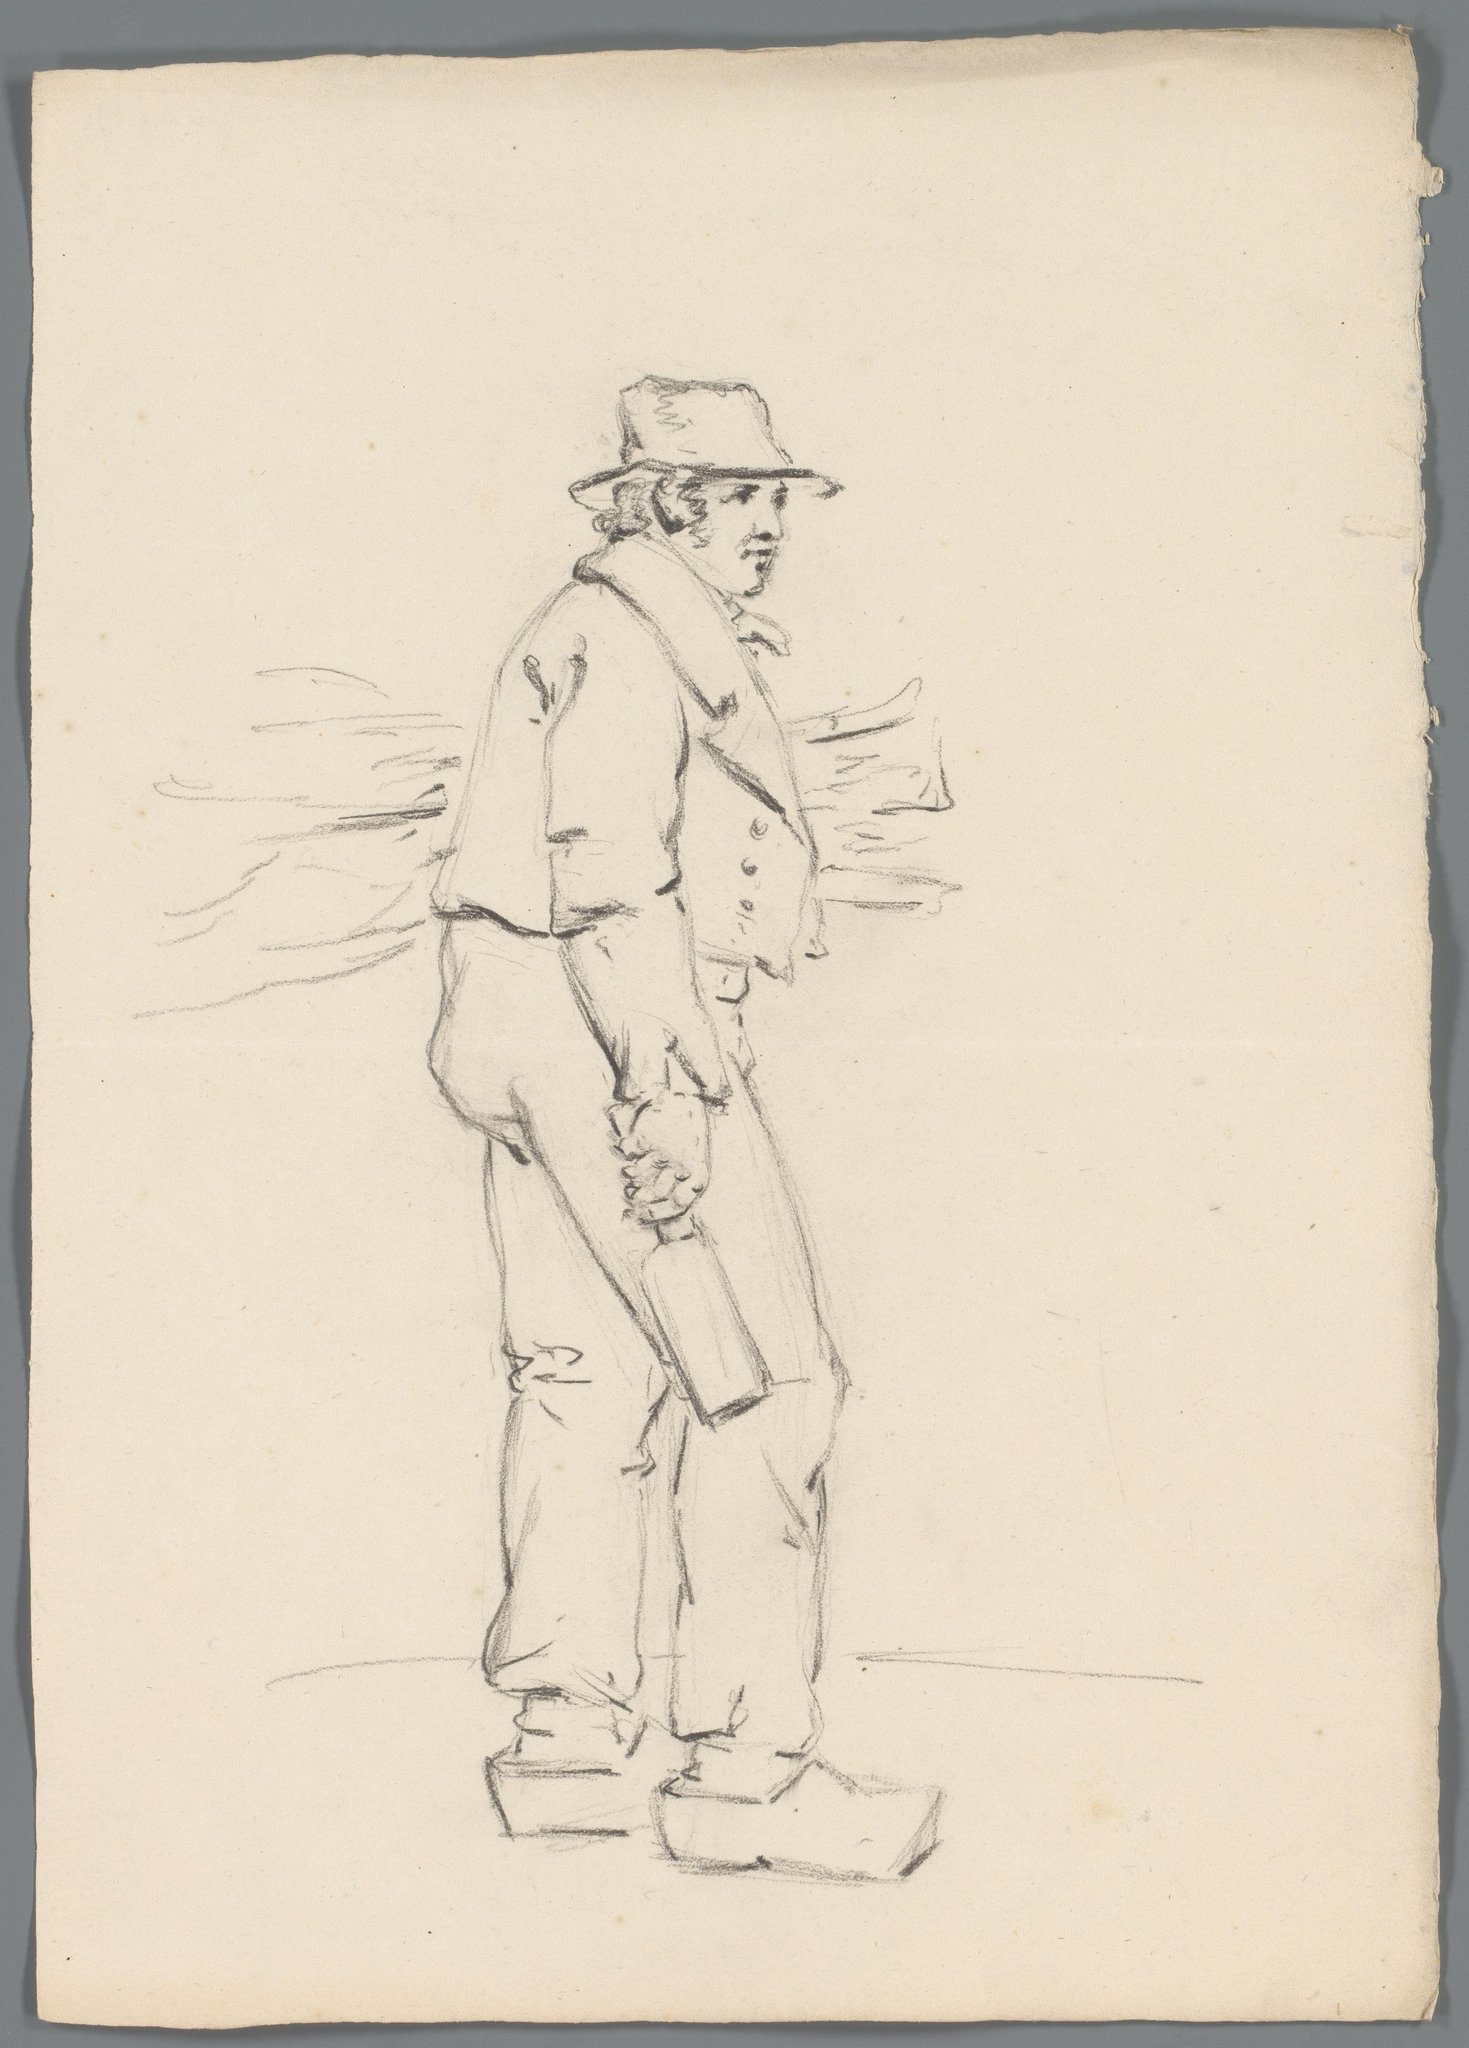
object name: drawing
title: Man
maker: Anonymous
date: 1820-1830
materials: chalk, paper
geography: the hague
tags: wooden shoes, clogs, adult man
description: Tekeningen waarschijnlijk ontstaan bij het Haagse kunstgenootschap ‘Tot Nut der Tekenkunst’, waar twee keer per week tekenavonden werden georganiseerd met geklede modellen.